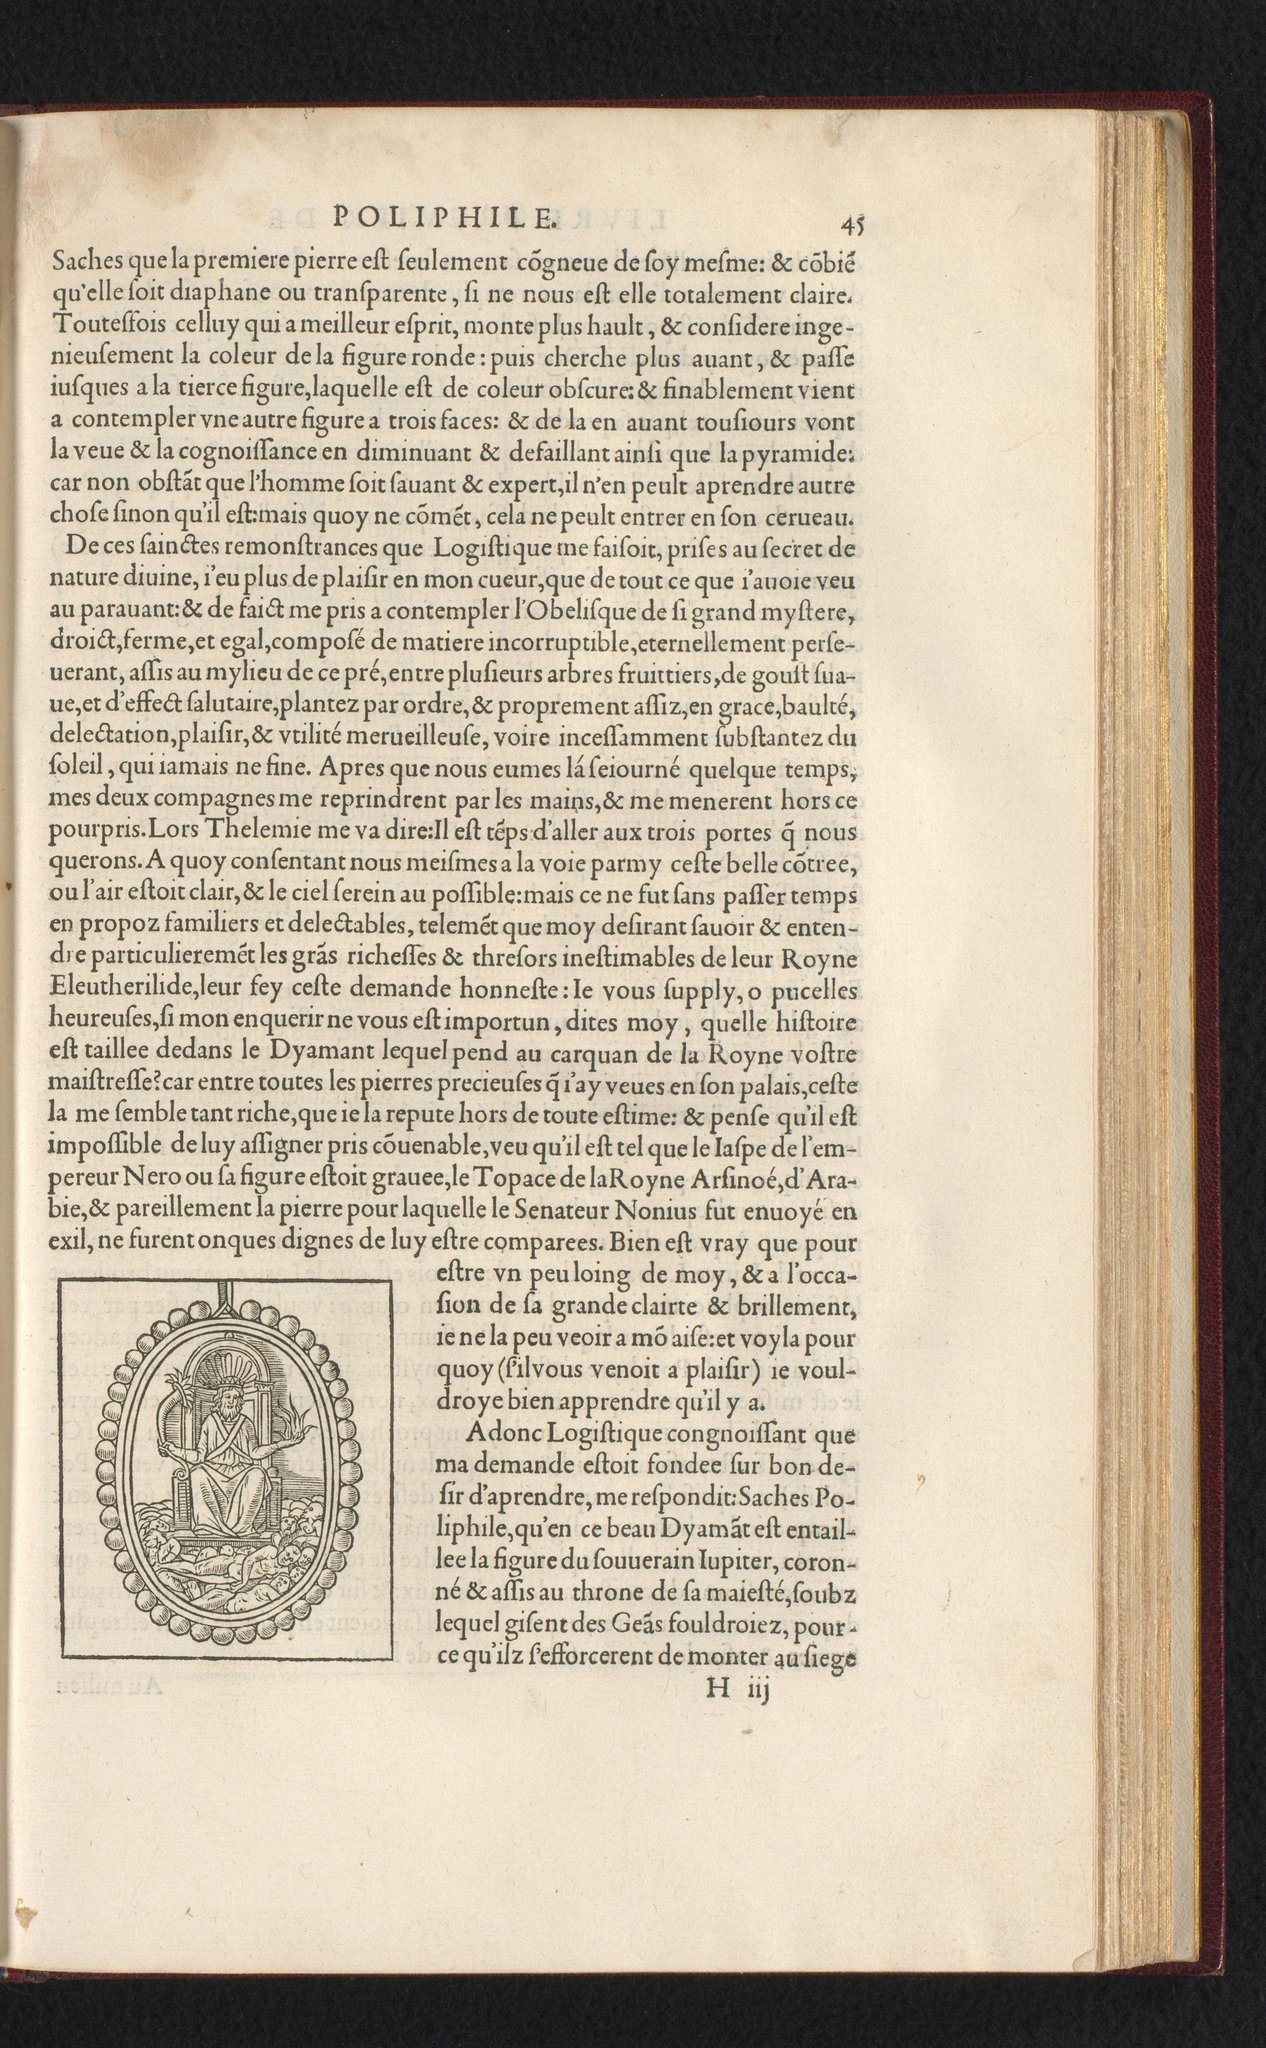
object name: book illustration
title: Medaillon met Jupiter op een troon boven de verslagen Giganten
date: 1546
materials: paper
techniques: letterpress printing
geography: paris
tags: battle of the giants against the gods: gigantomachy, (story of) jupiter (zeus), (scenes from) specific works of literature: colonna, hypnerotomachia poliphili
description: Prent uit: Colonna, Francesco. Hypnerotomachie ou discours du songe de Poliphile, deduisant comme amour le combat a l'occasion de Polia. Parijs: Jacques Kerver, 1546, recto fol. 45.